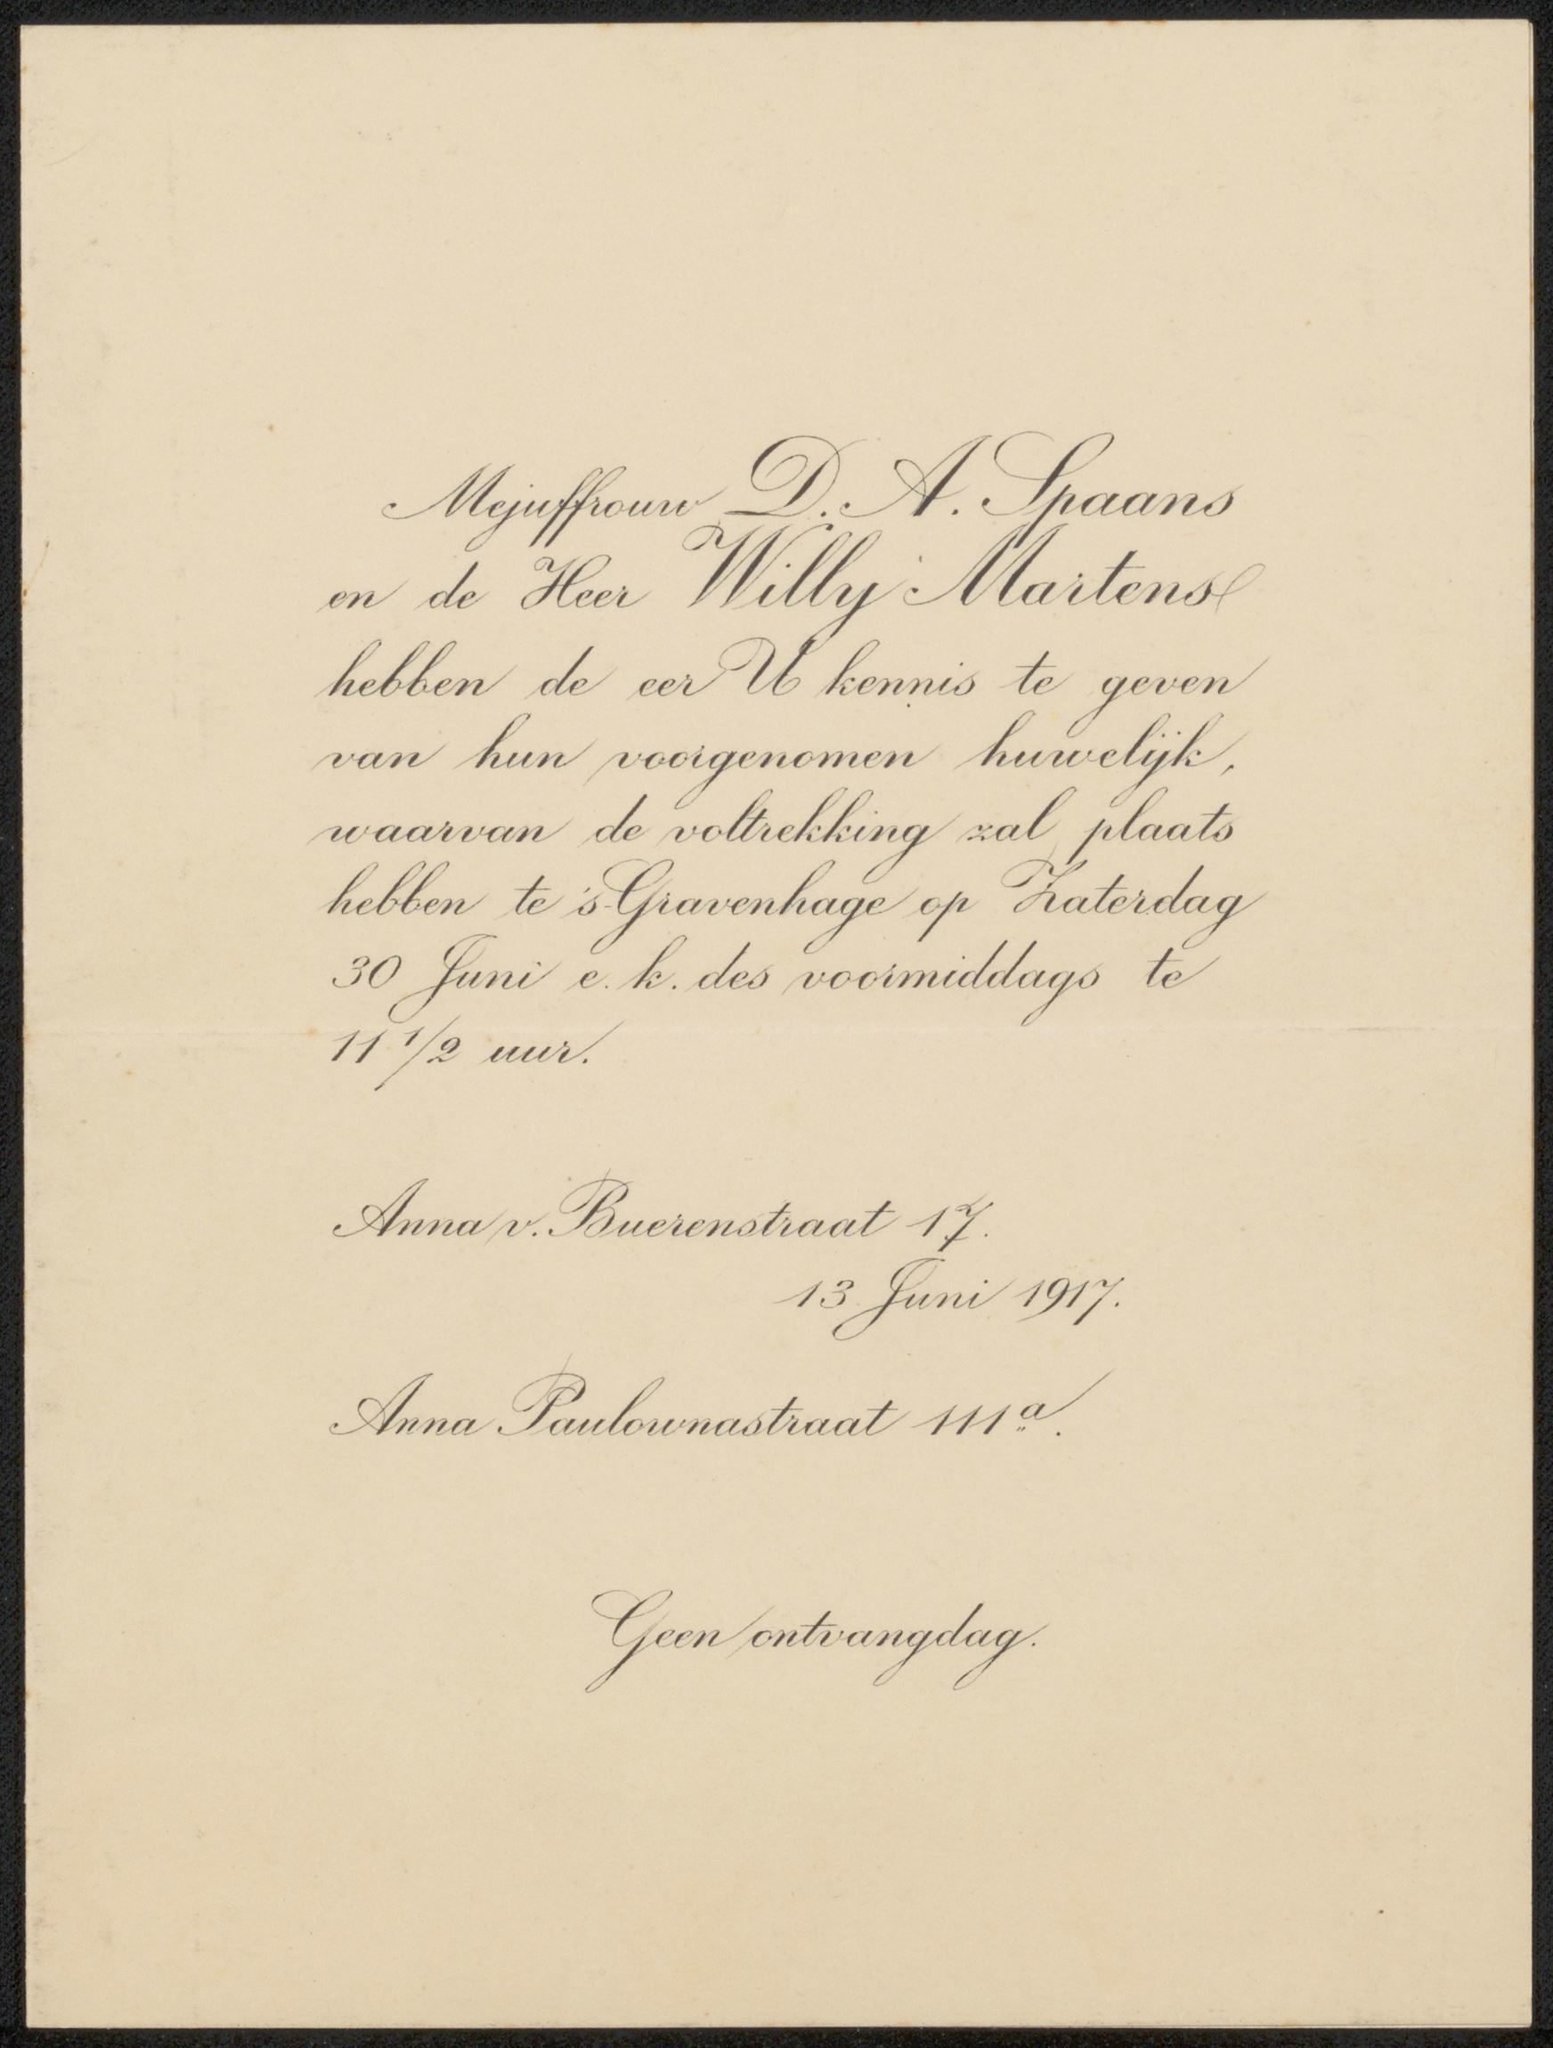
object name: wedding announcement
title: Huwelijksaankondiging aan Philip Zilcken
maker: Anonymous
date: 1917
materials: paper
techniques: printing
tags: willy martens, the hague, painter, draughtsman, philip zilcken